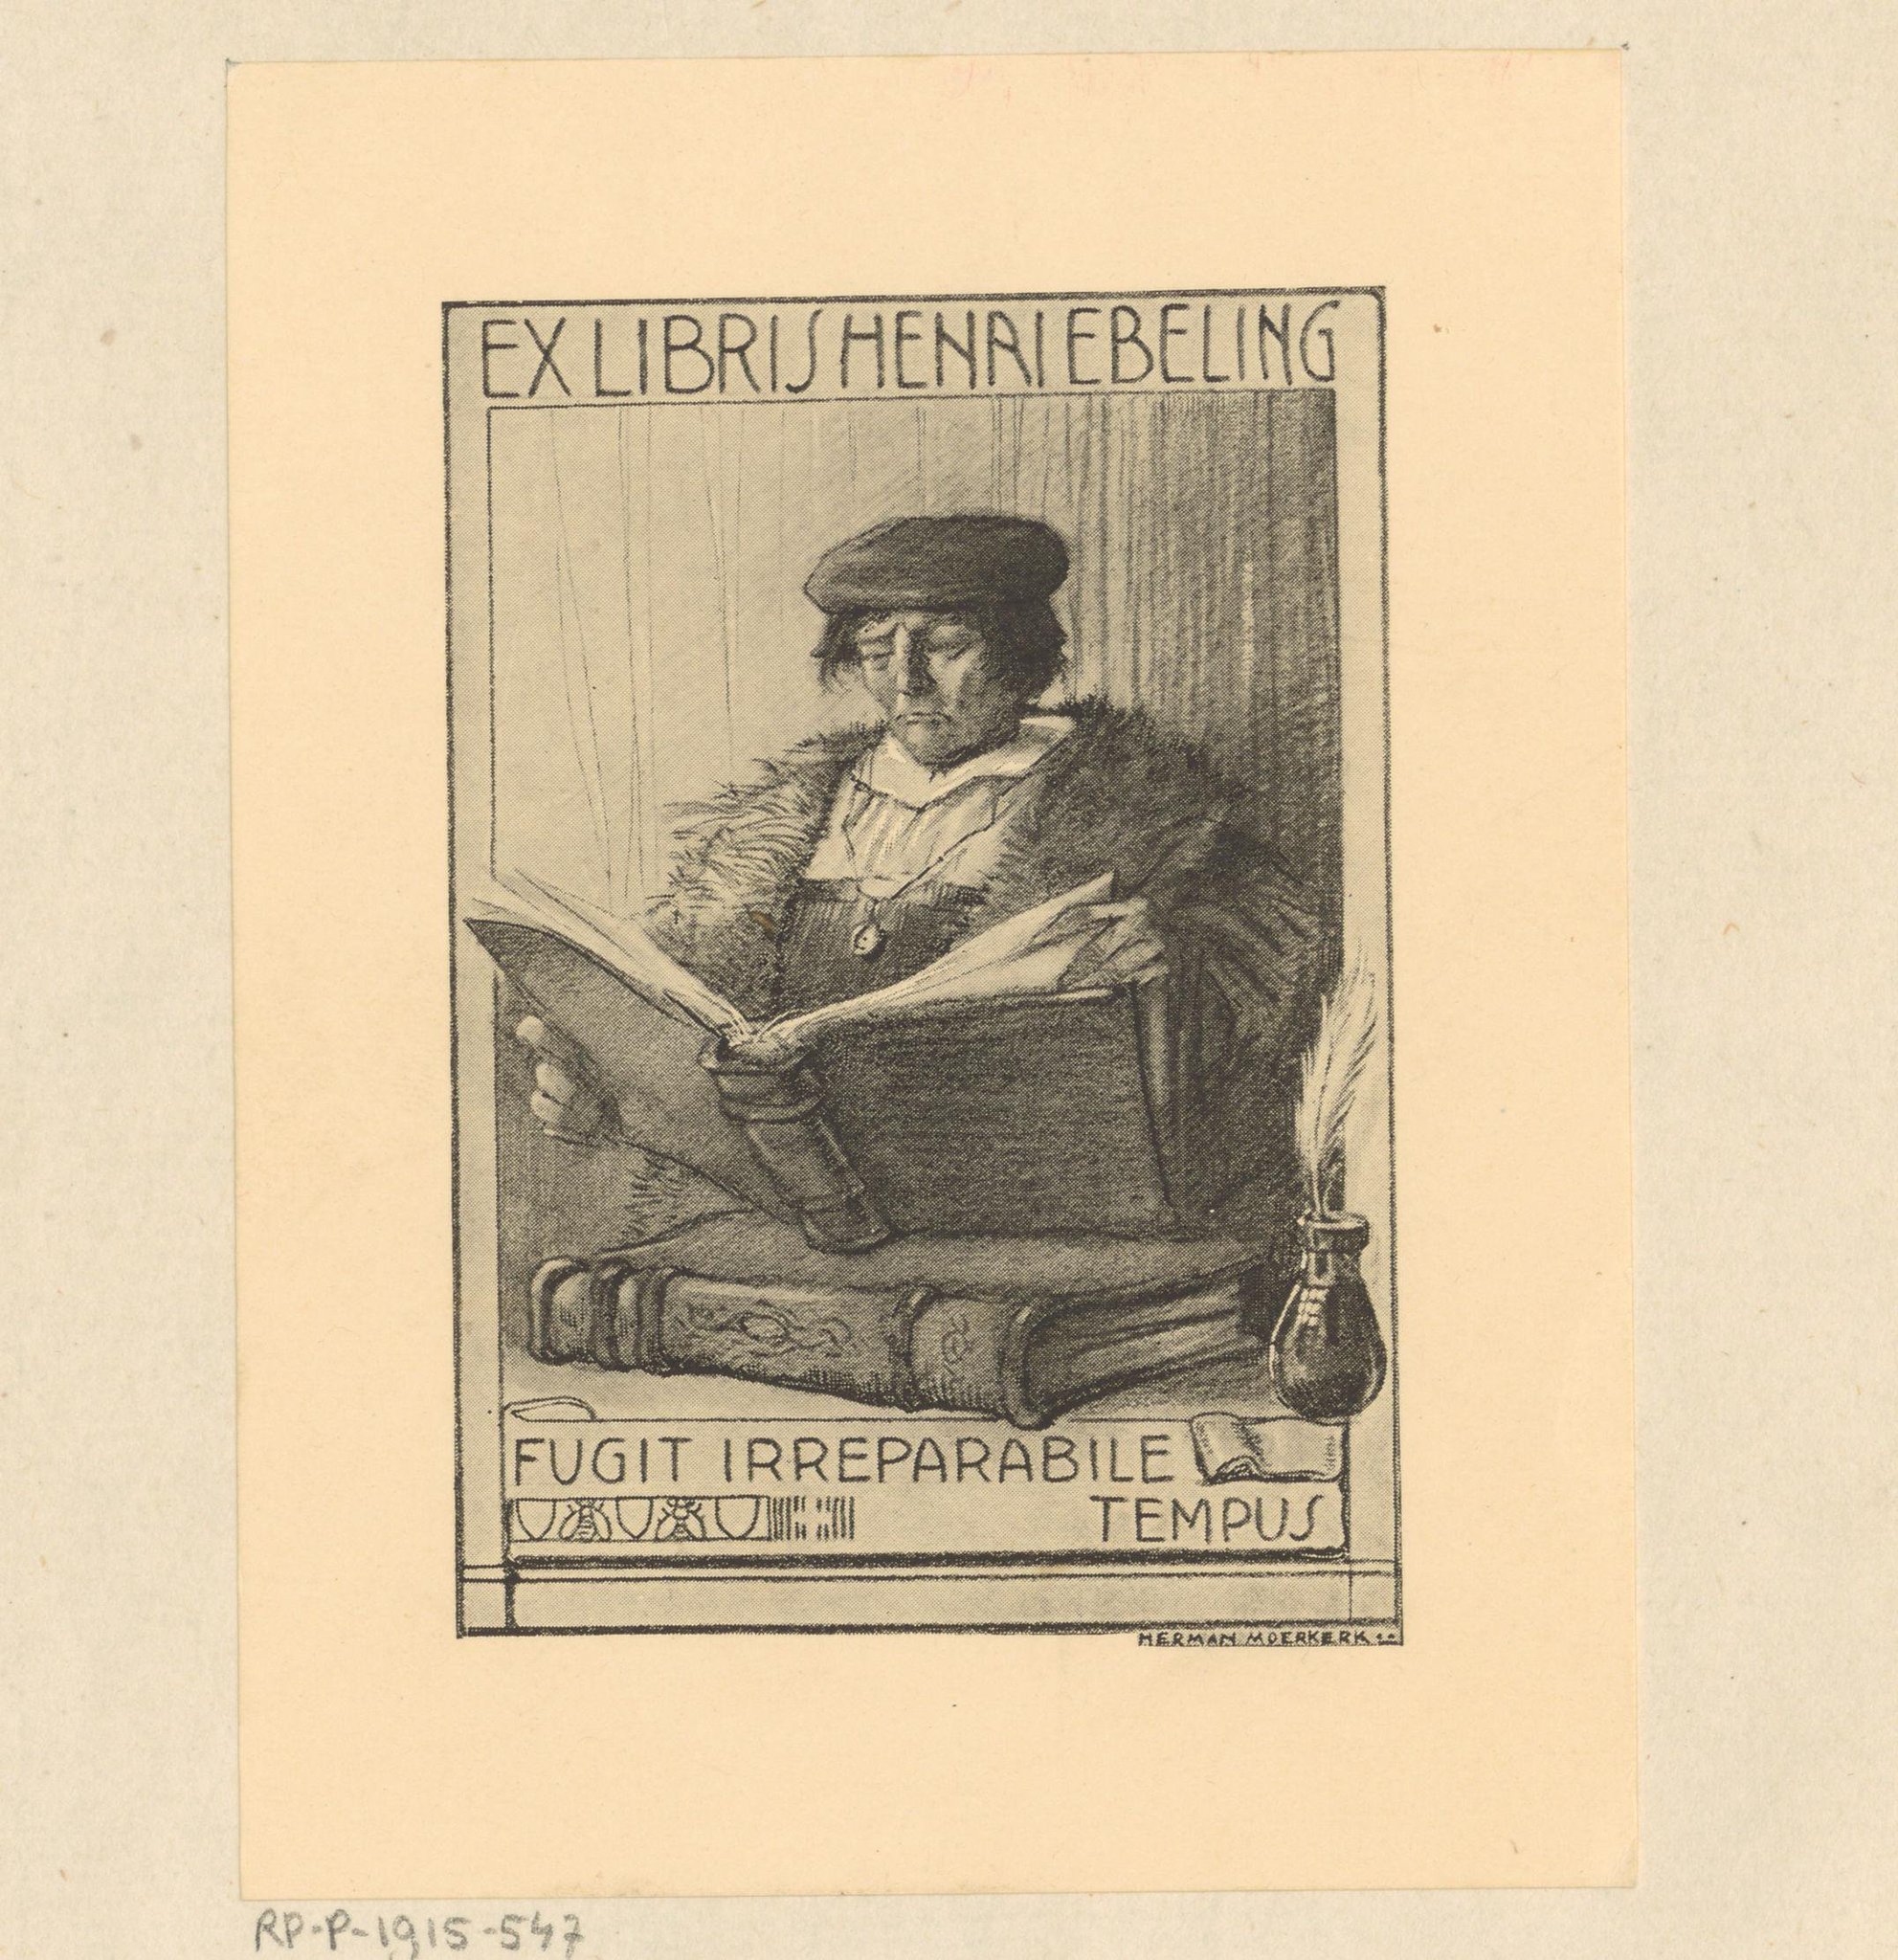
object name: bookplate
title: Ex libris van Henri Ebeling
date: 1915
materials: paper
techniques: autotype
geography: netherlands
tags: scholar in his study, reading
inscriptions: collector's mark: Lugt 2233